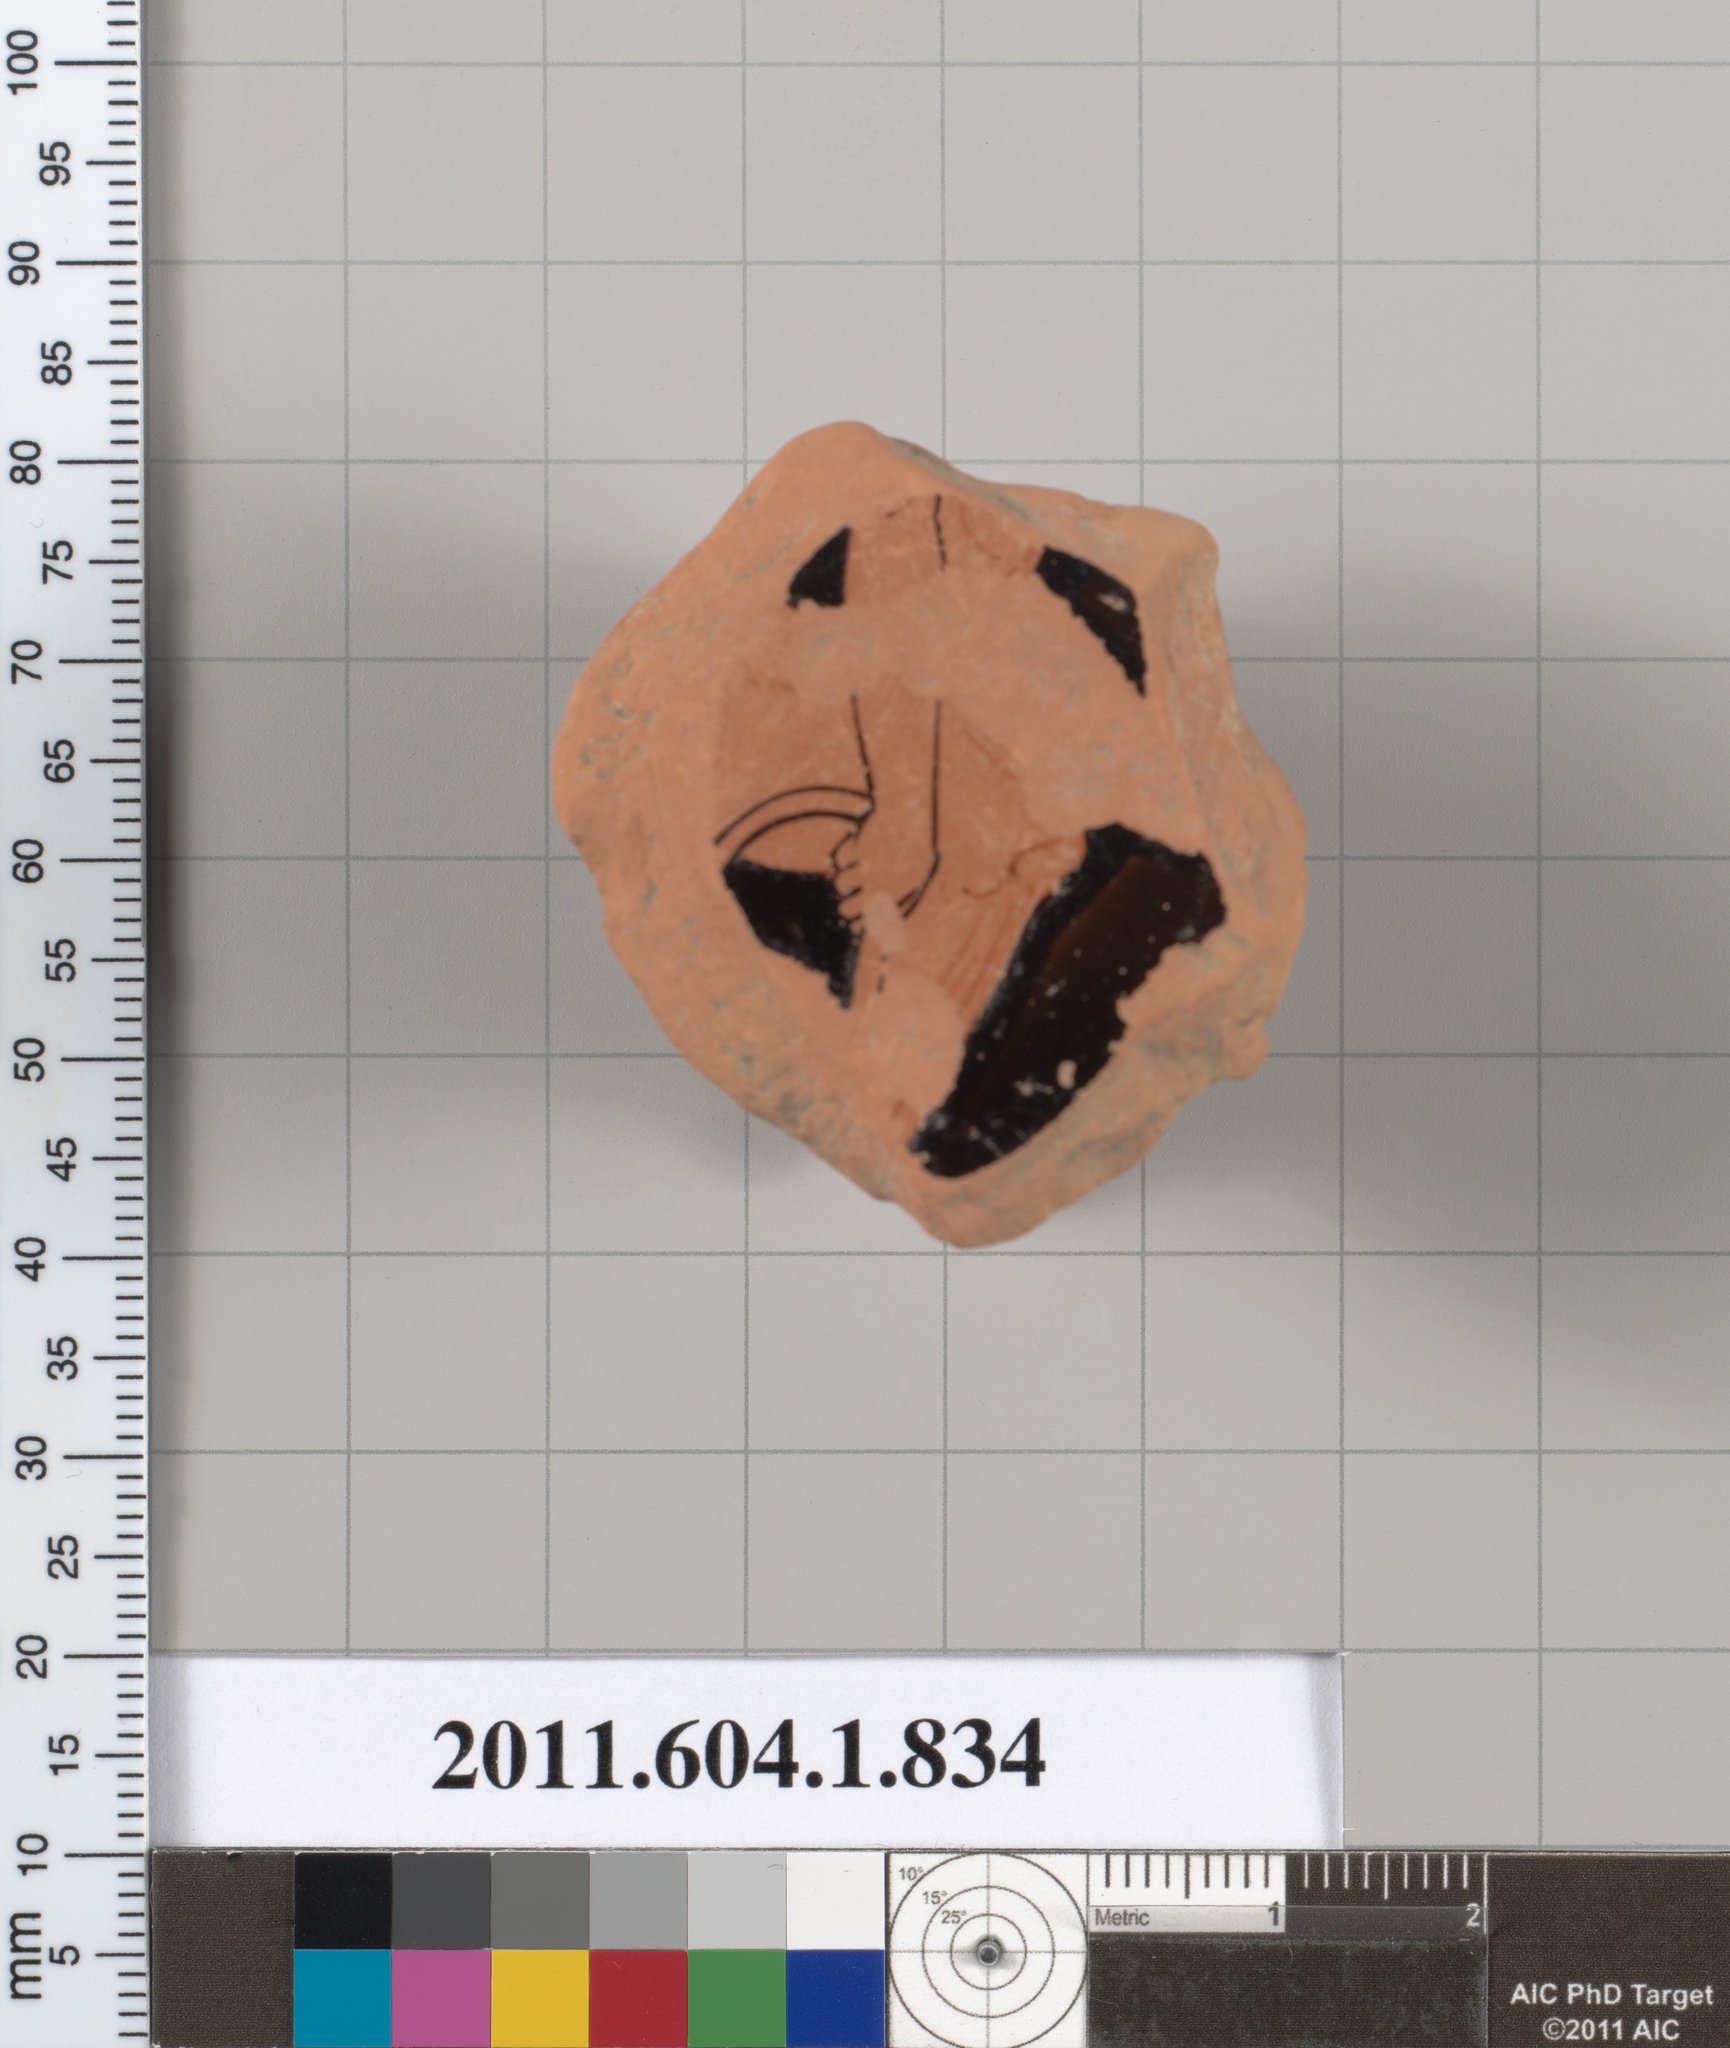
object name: kylix fragment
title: Terracotta fragment of a kylix (drinking cup)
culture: greek, attic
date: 475-451 BCE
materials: terracotta